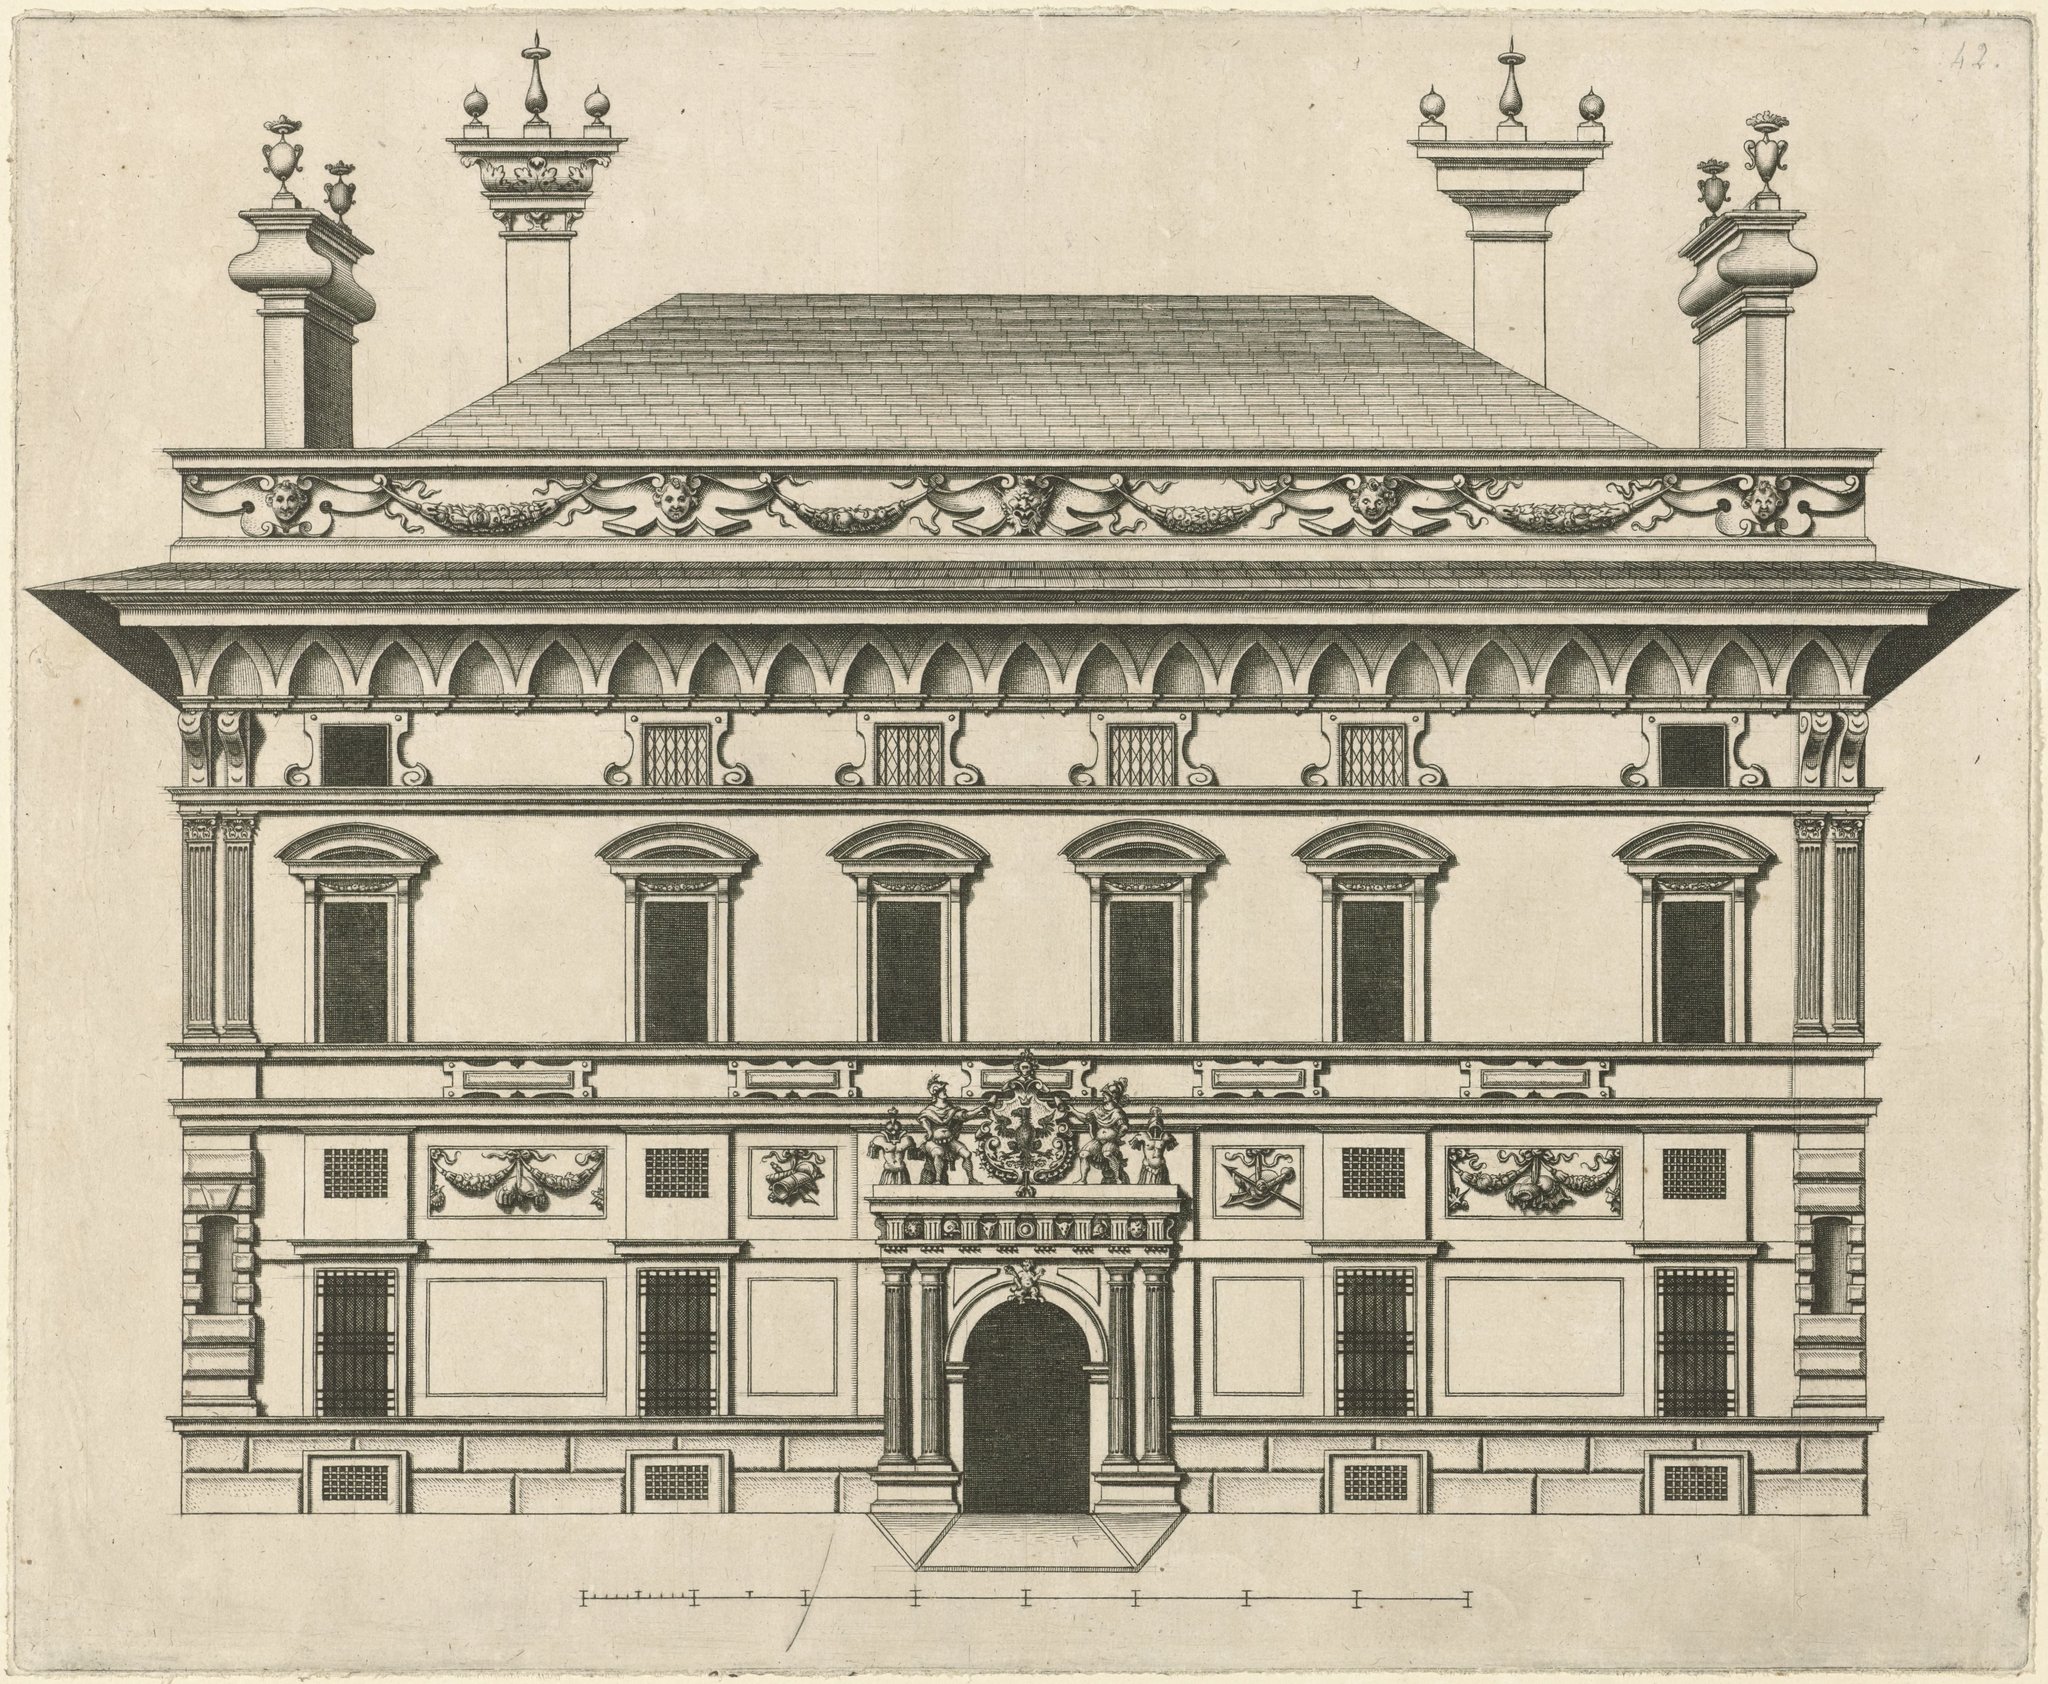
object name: print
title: Palazzo Doria Spinola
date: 1622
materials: paper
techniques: engraving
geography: antwerp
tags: façade (of house or building)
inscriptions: collector's mark: Lugt 240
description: Voorgevel van Palazzo Doria Spinola (Prefettura), gelegen aan de largo Lanfranco te Genua. Het palazzo werd tussen 1541 en 1543 gebouwd.